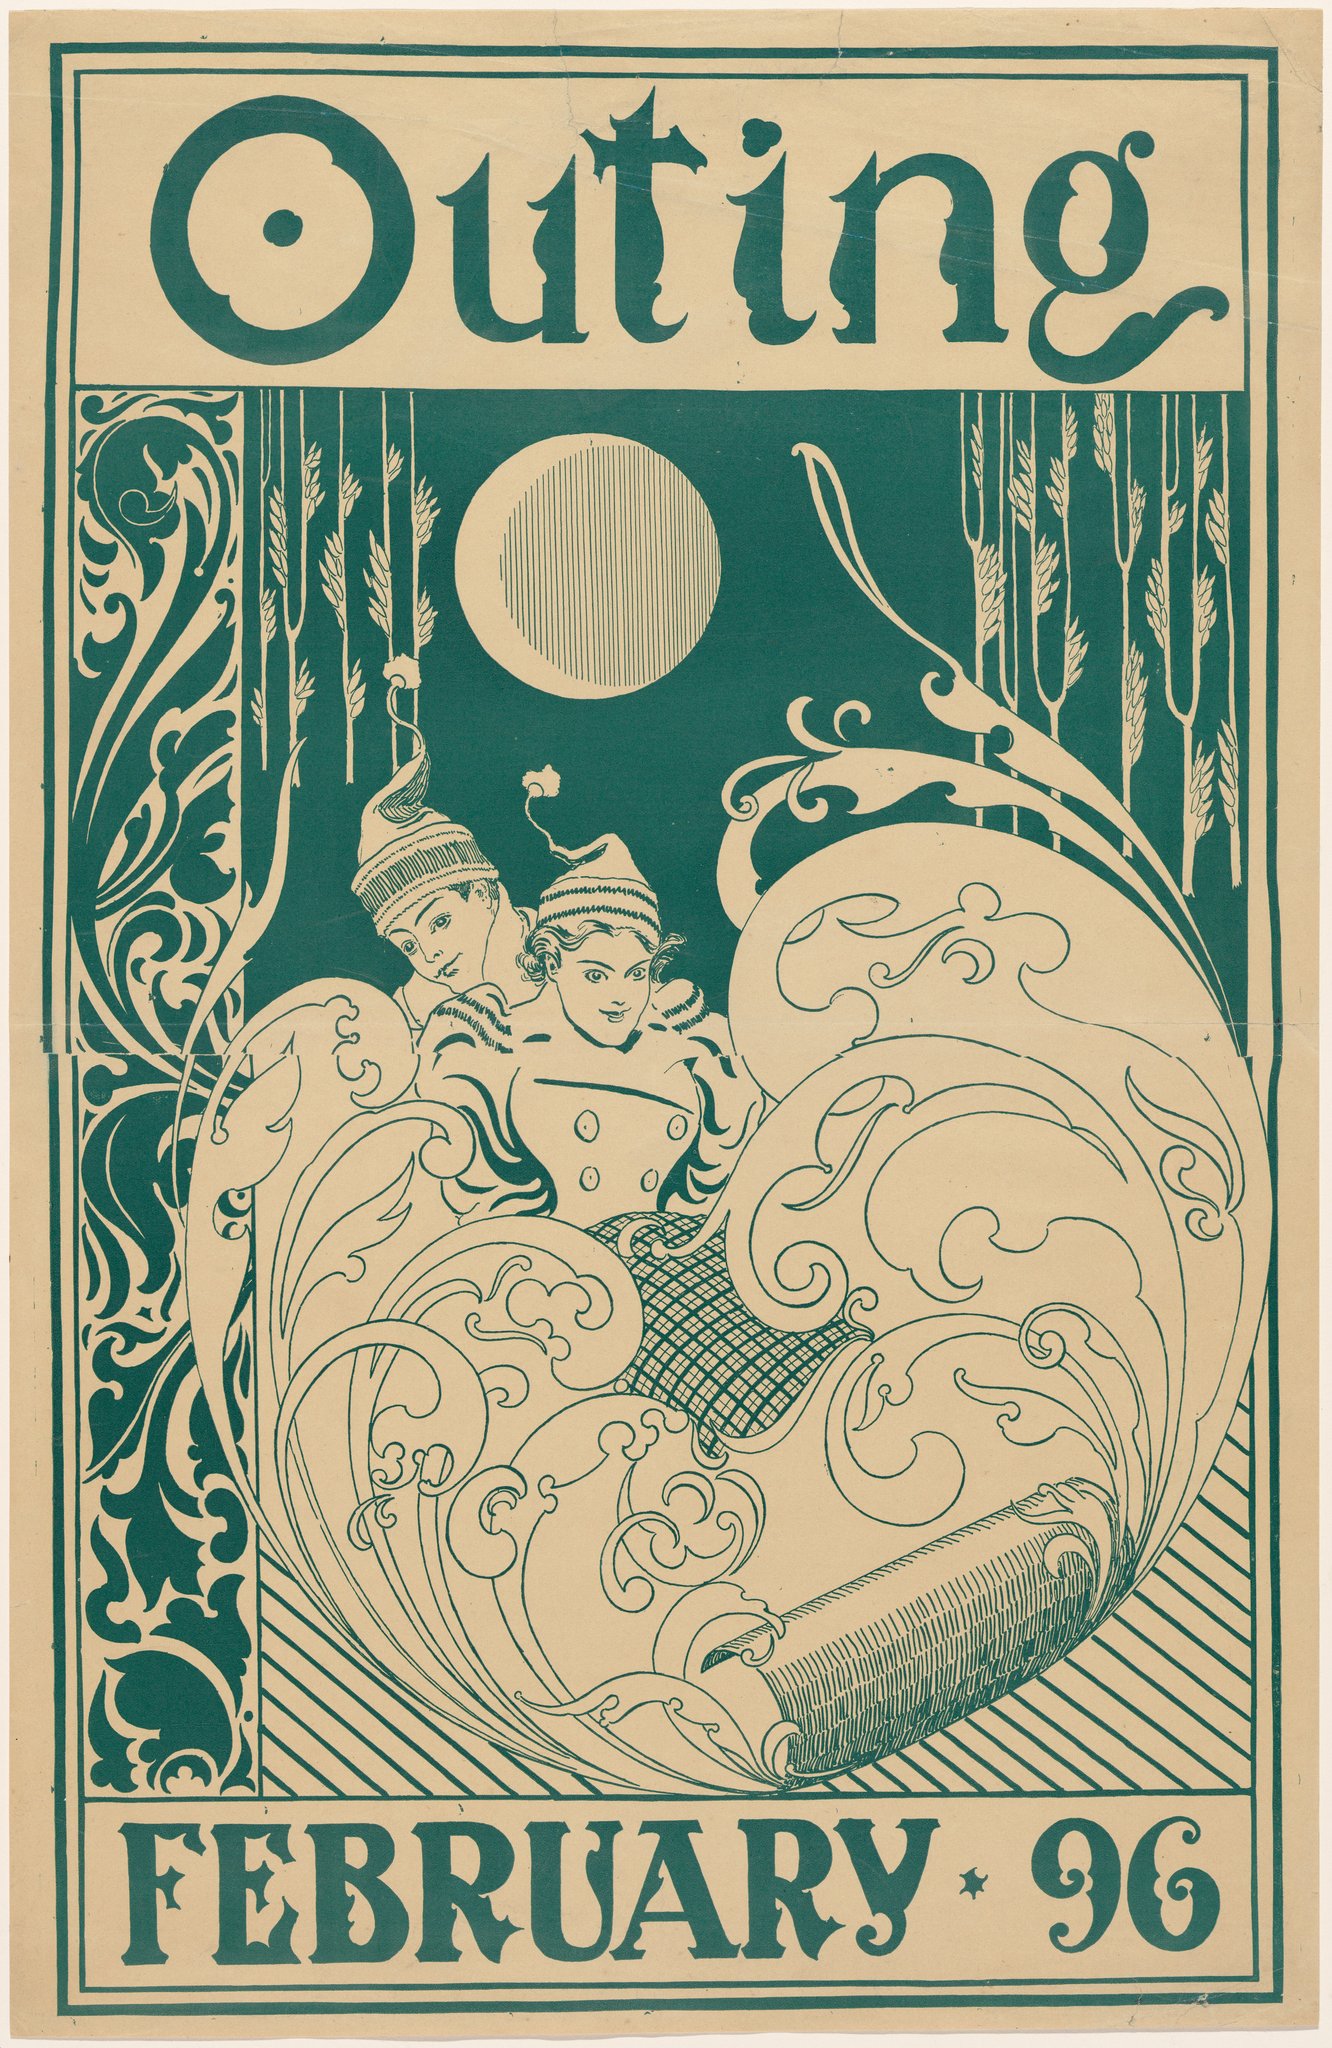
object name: print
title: Outing, February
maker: anonymous, american, 19th century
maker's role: artist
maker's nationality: american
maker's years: 1800-1900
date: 1896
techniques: lithograph